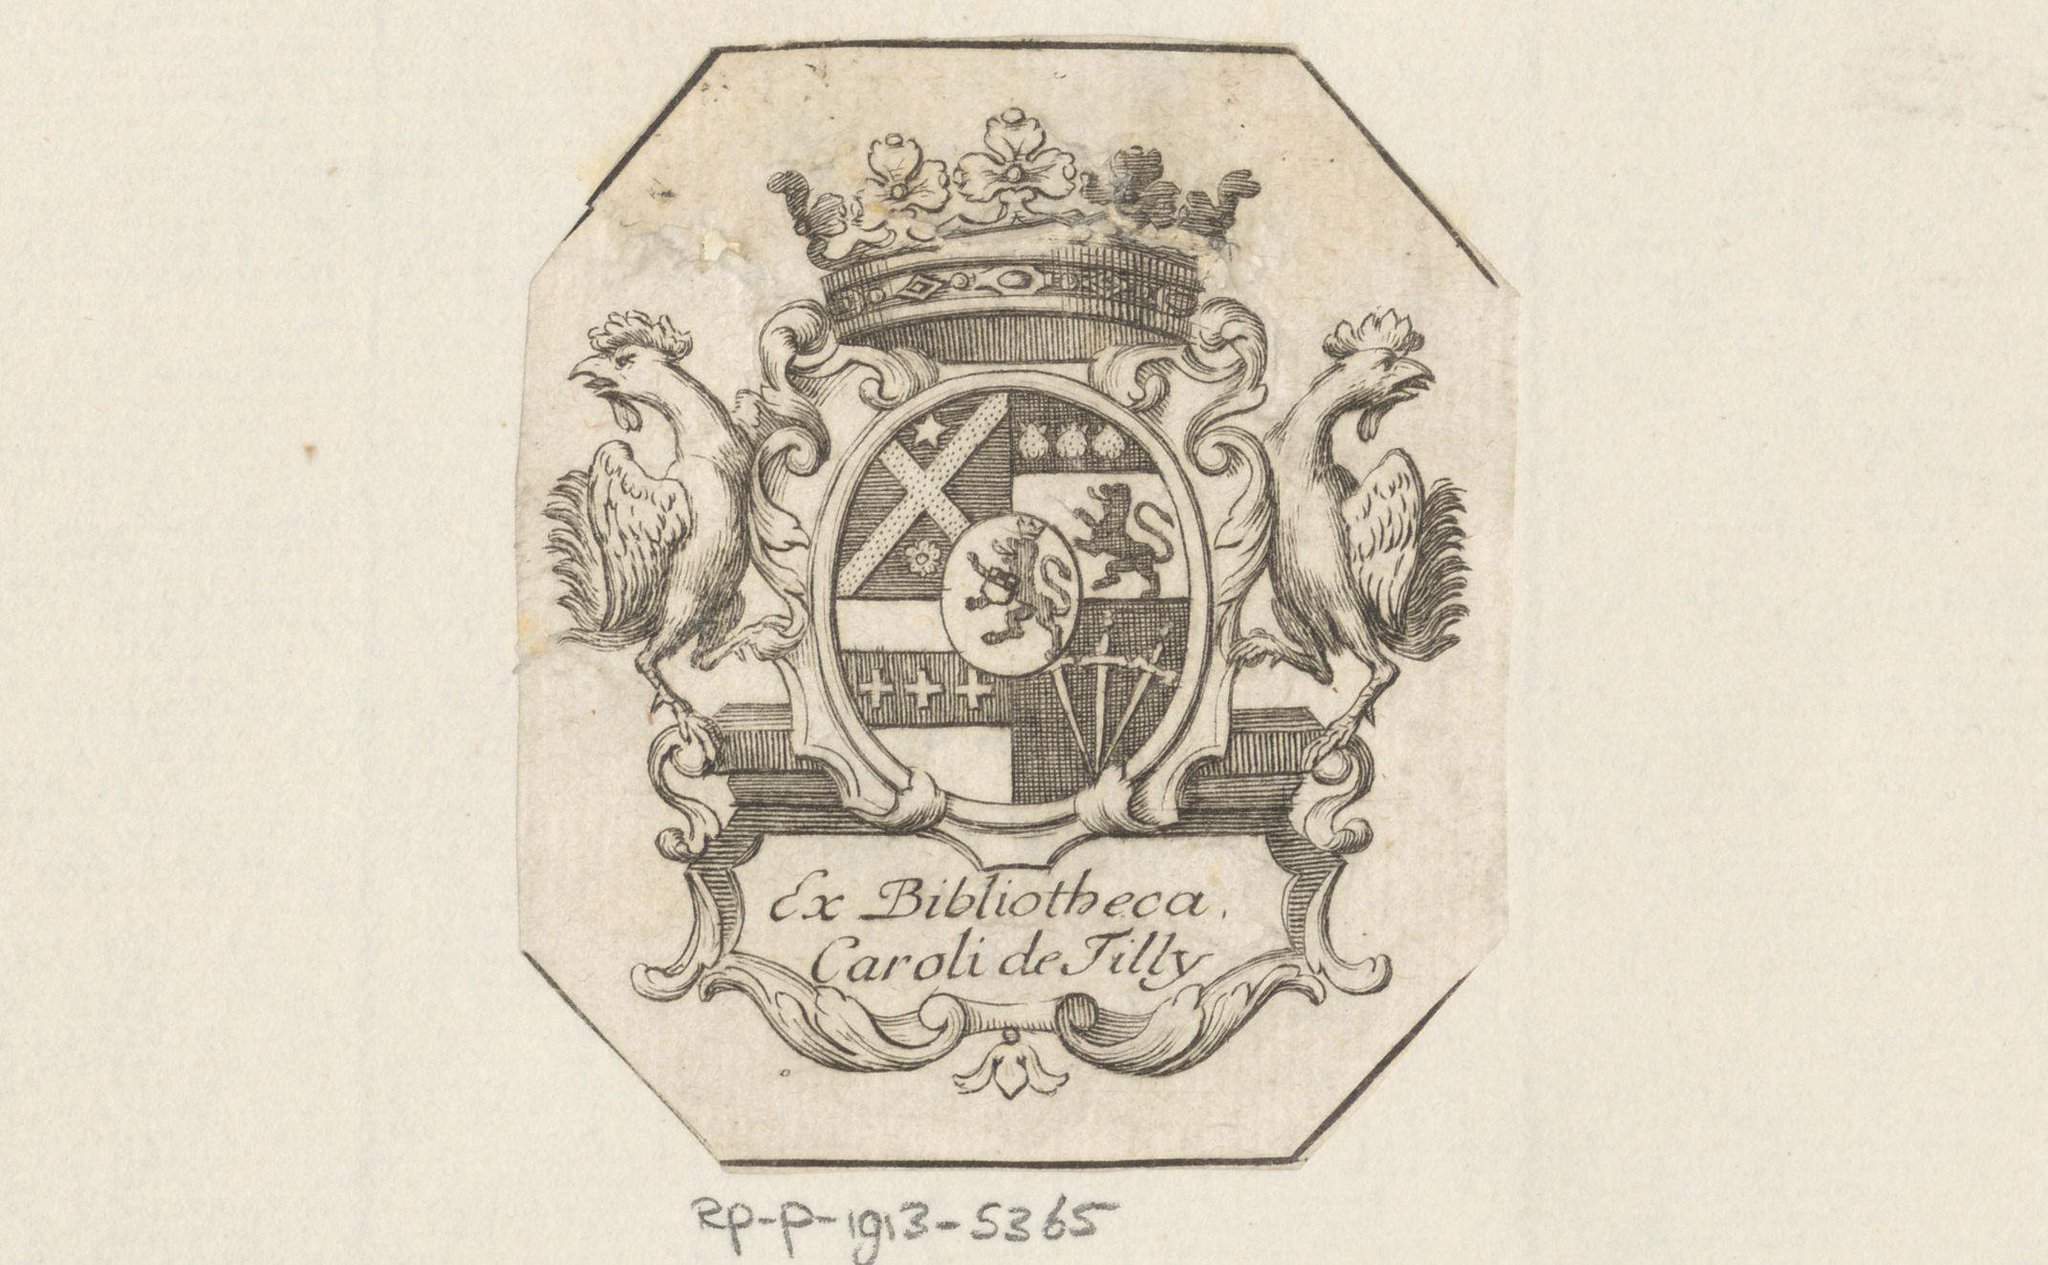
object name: bookplate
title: Ex libris van Caroli de Tilly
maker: Anonymous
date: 1750-1849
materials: paper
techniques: engraving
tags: armorial bearing, heraldry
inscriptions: collector's mark: Lugt 2760, collector's mark: Lugt 2233